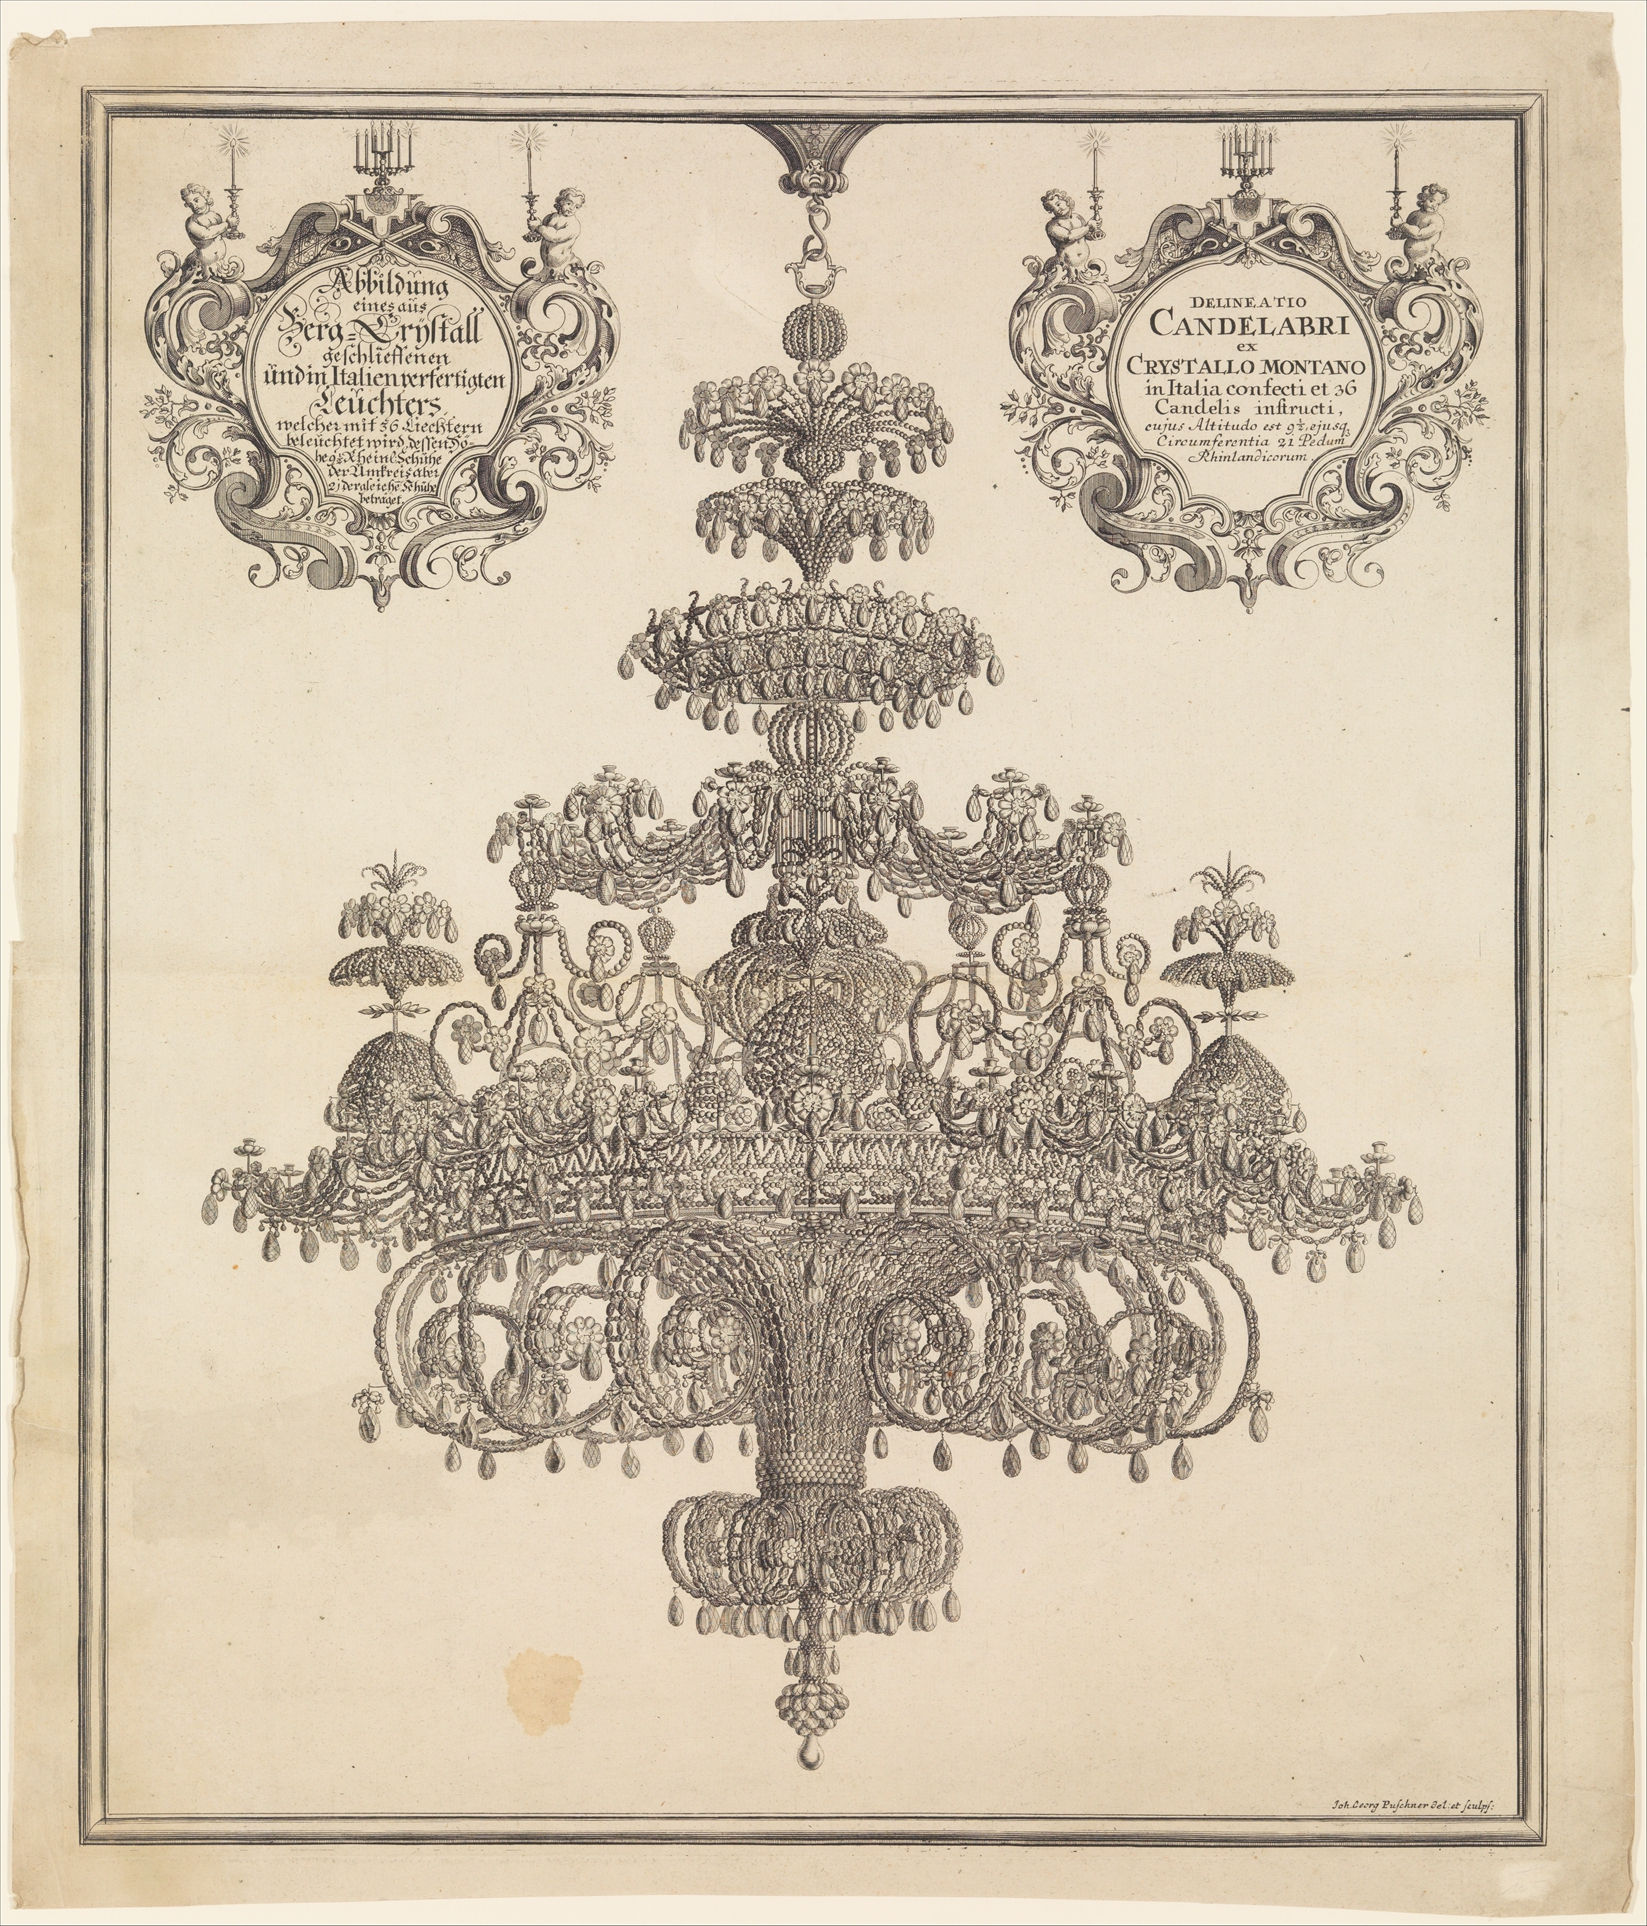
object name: print ornament architecture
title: Rock Crystal Chandelier from the so-called 'White Peller's House' [weiße Pellershaus] in Nuremberg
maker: johann georg puschner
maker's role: artist and architect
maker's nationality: german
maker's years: 1680-1749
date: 1700-1720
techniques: engraving, etching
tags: chandelier